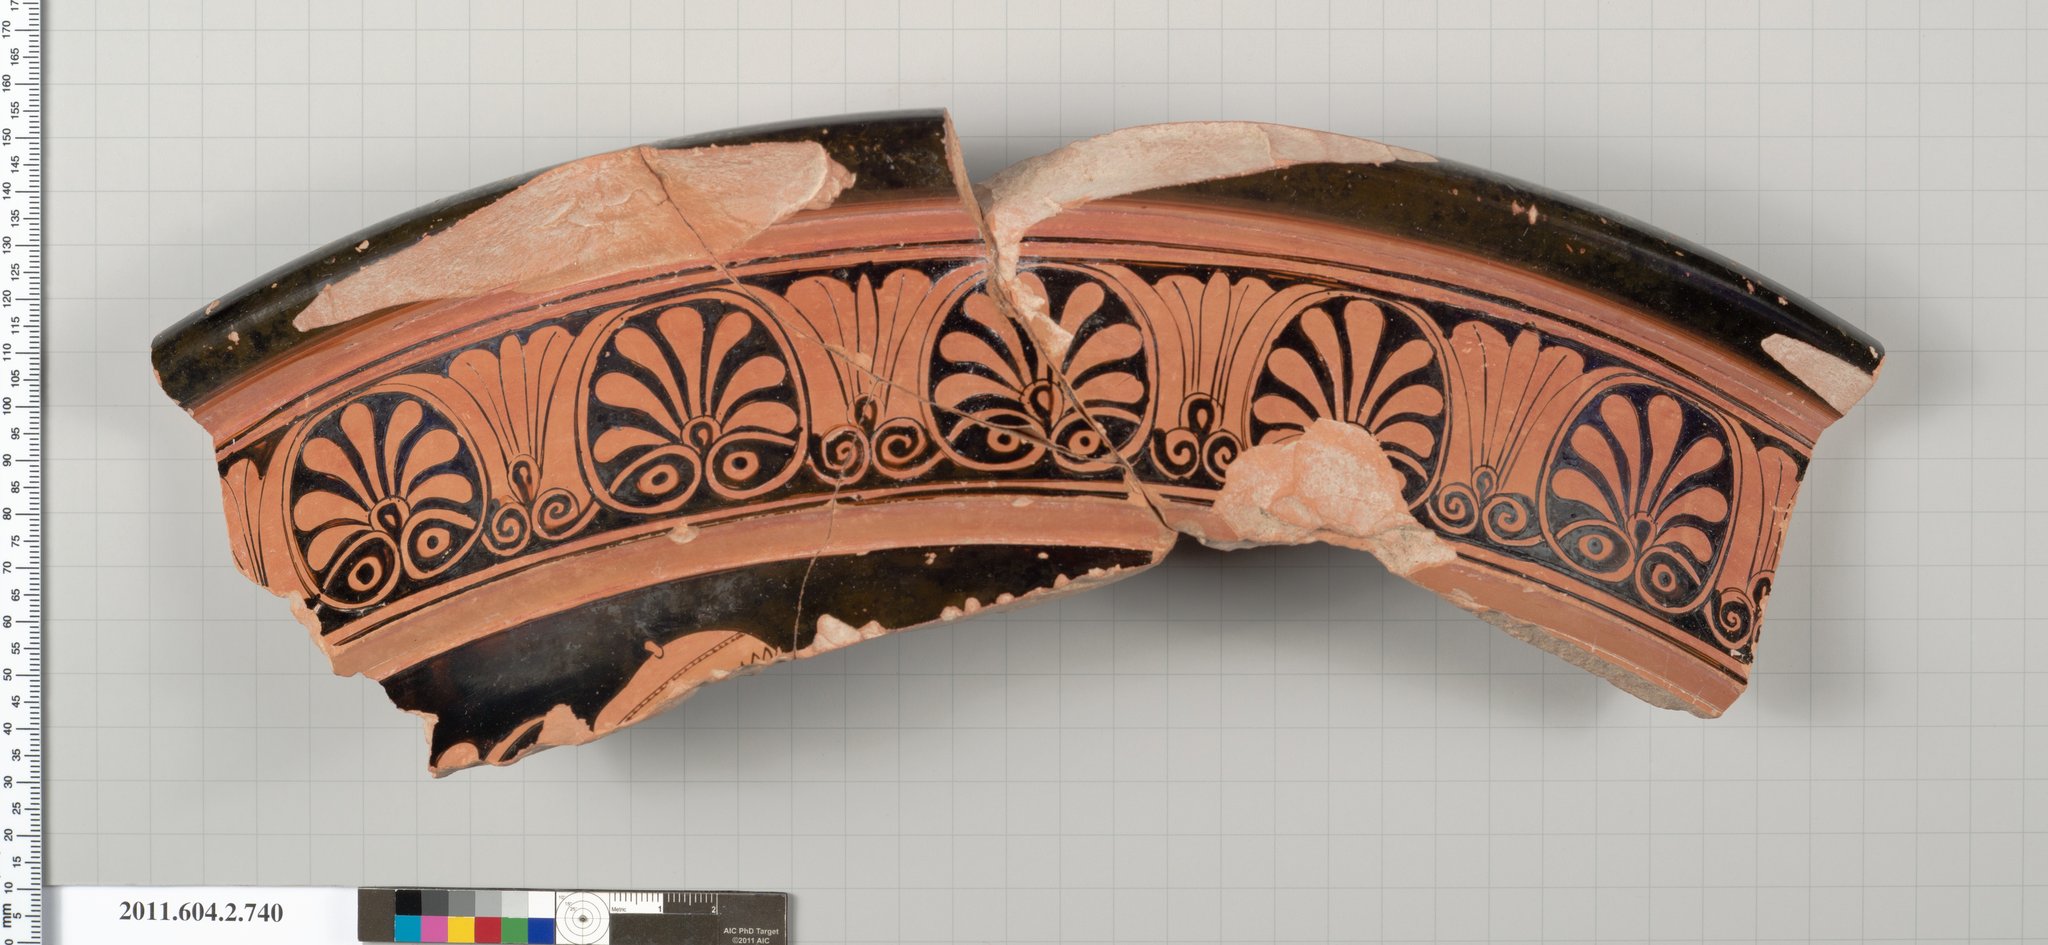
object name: calyx krater fragment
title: Terracotta fragment of a calyx-krater (bowl for mixing wine and water)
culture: greek, attic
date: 475-451 BCE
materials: terracotta